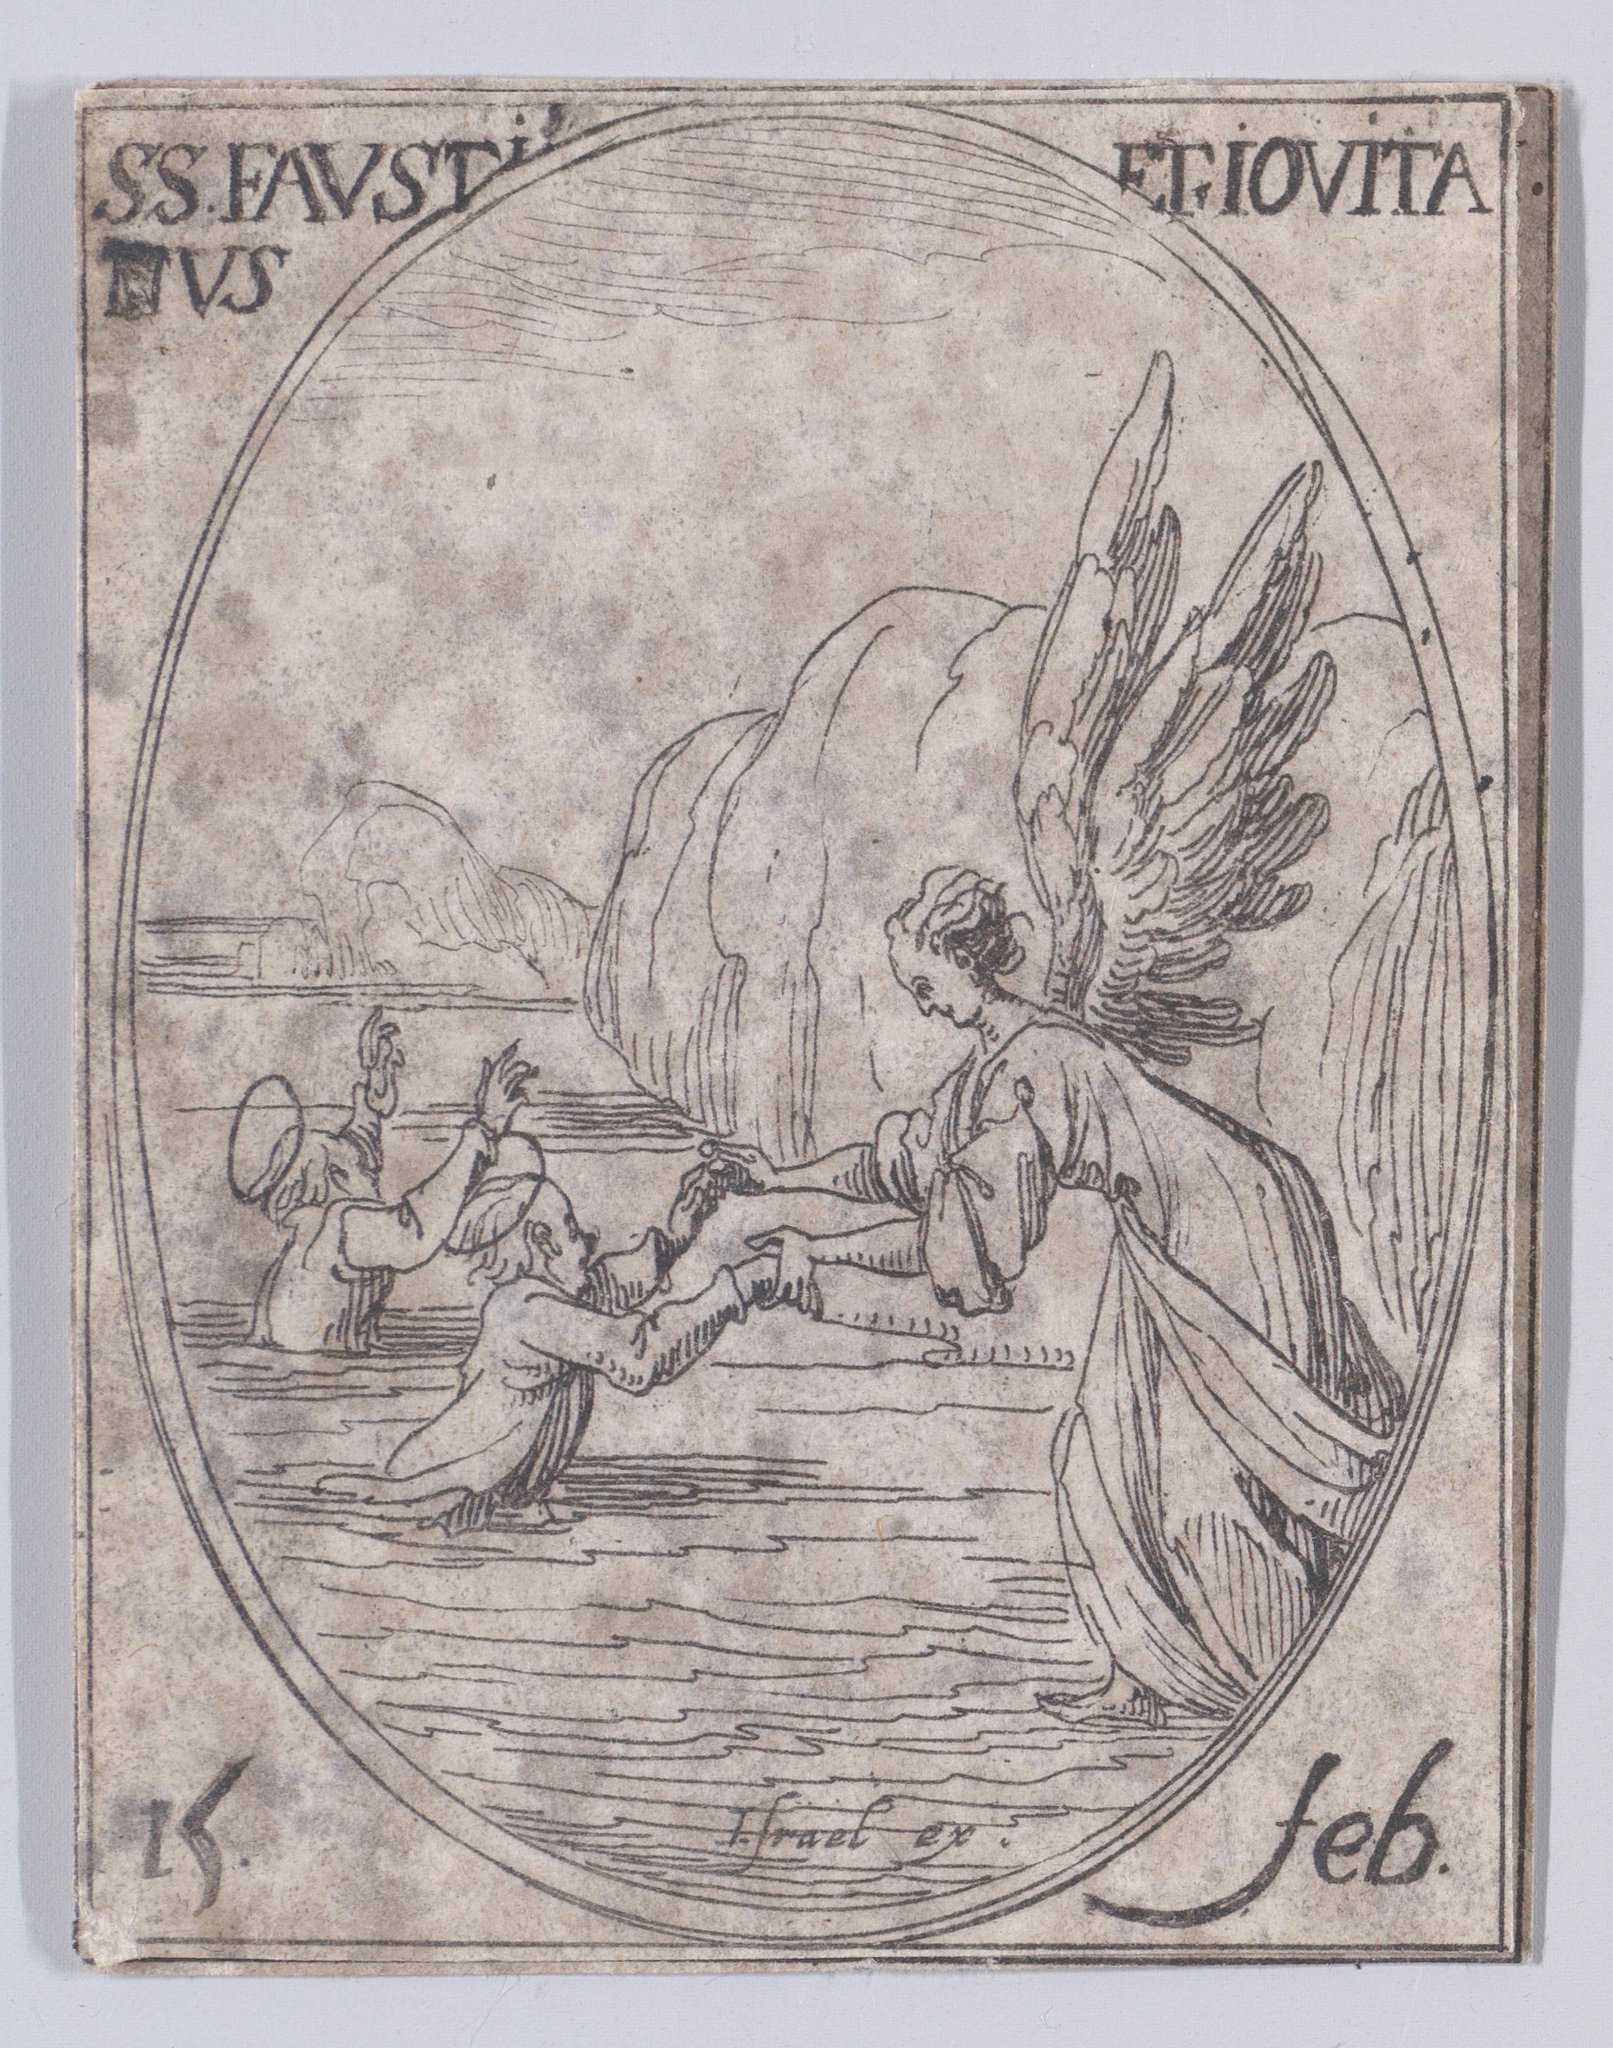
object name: print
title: S. Faustin et S. Jovite (St. Faustinus and St. Jovita), February 15th, from "Les Images De Tous Les Saincts et Saintes de L'Année" (Images of All of the Saints and Religious Events of the Year)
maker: jacques callot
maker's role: artist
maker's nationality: french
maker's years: 1592-1635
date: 1636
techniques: etching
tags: angels,saints